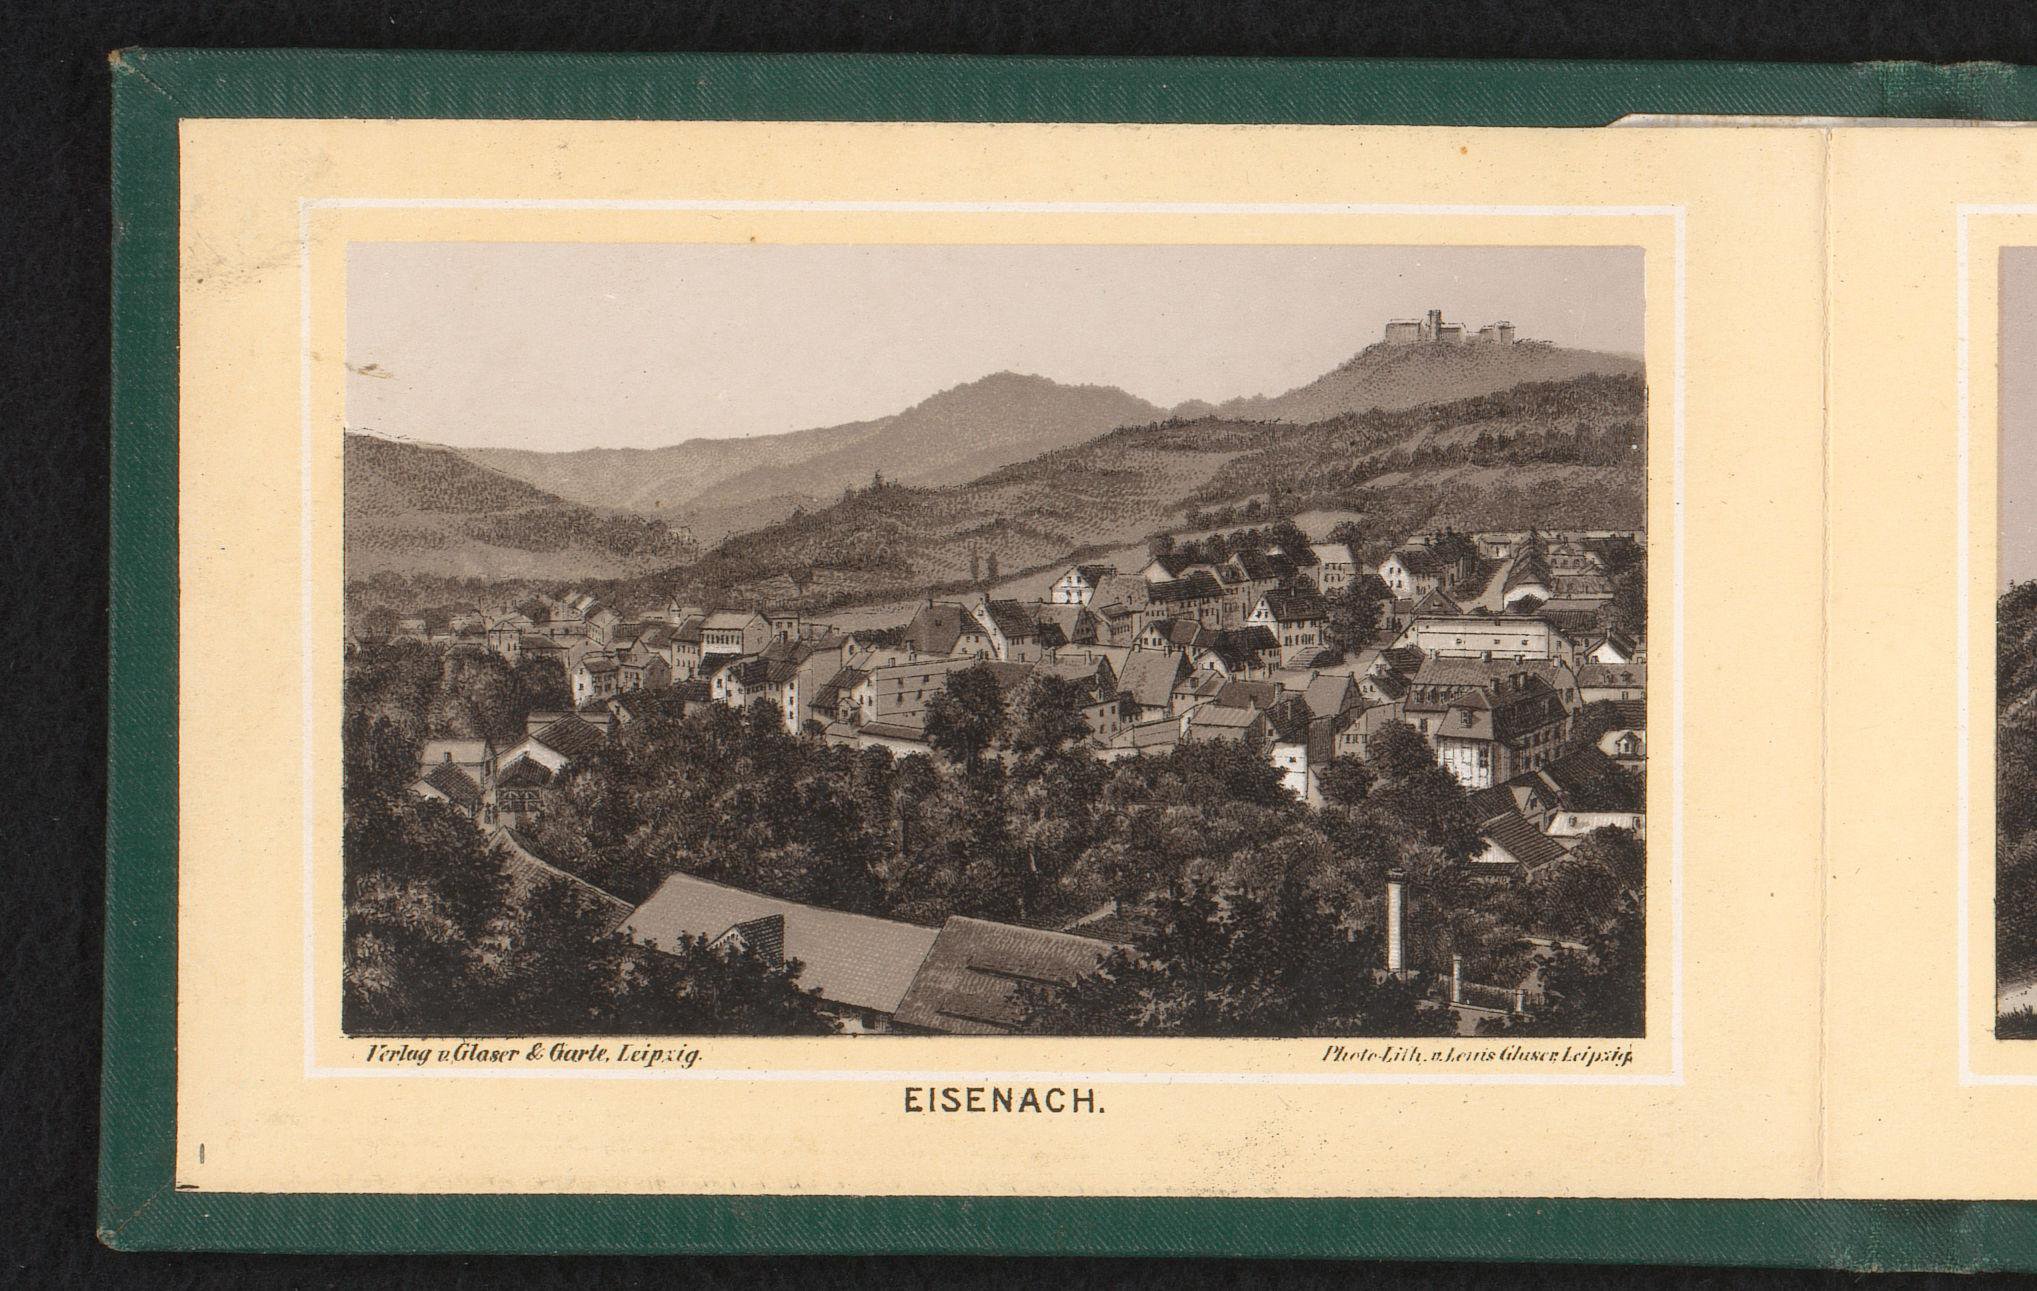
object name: photomechanical print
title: Eisenach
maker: louis glaser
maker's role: printer, publisher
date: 1874-1900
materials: cardboard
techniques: photolithography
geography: leipzig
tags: city-view, and landscape with man-made constructions, mountains